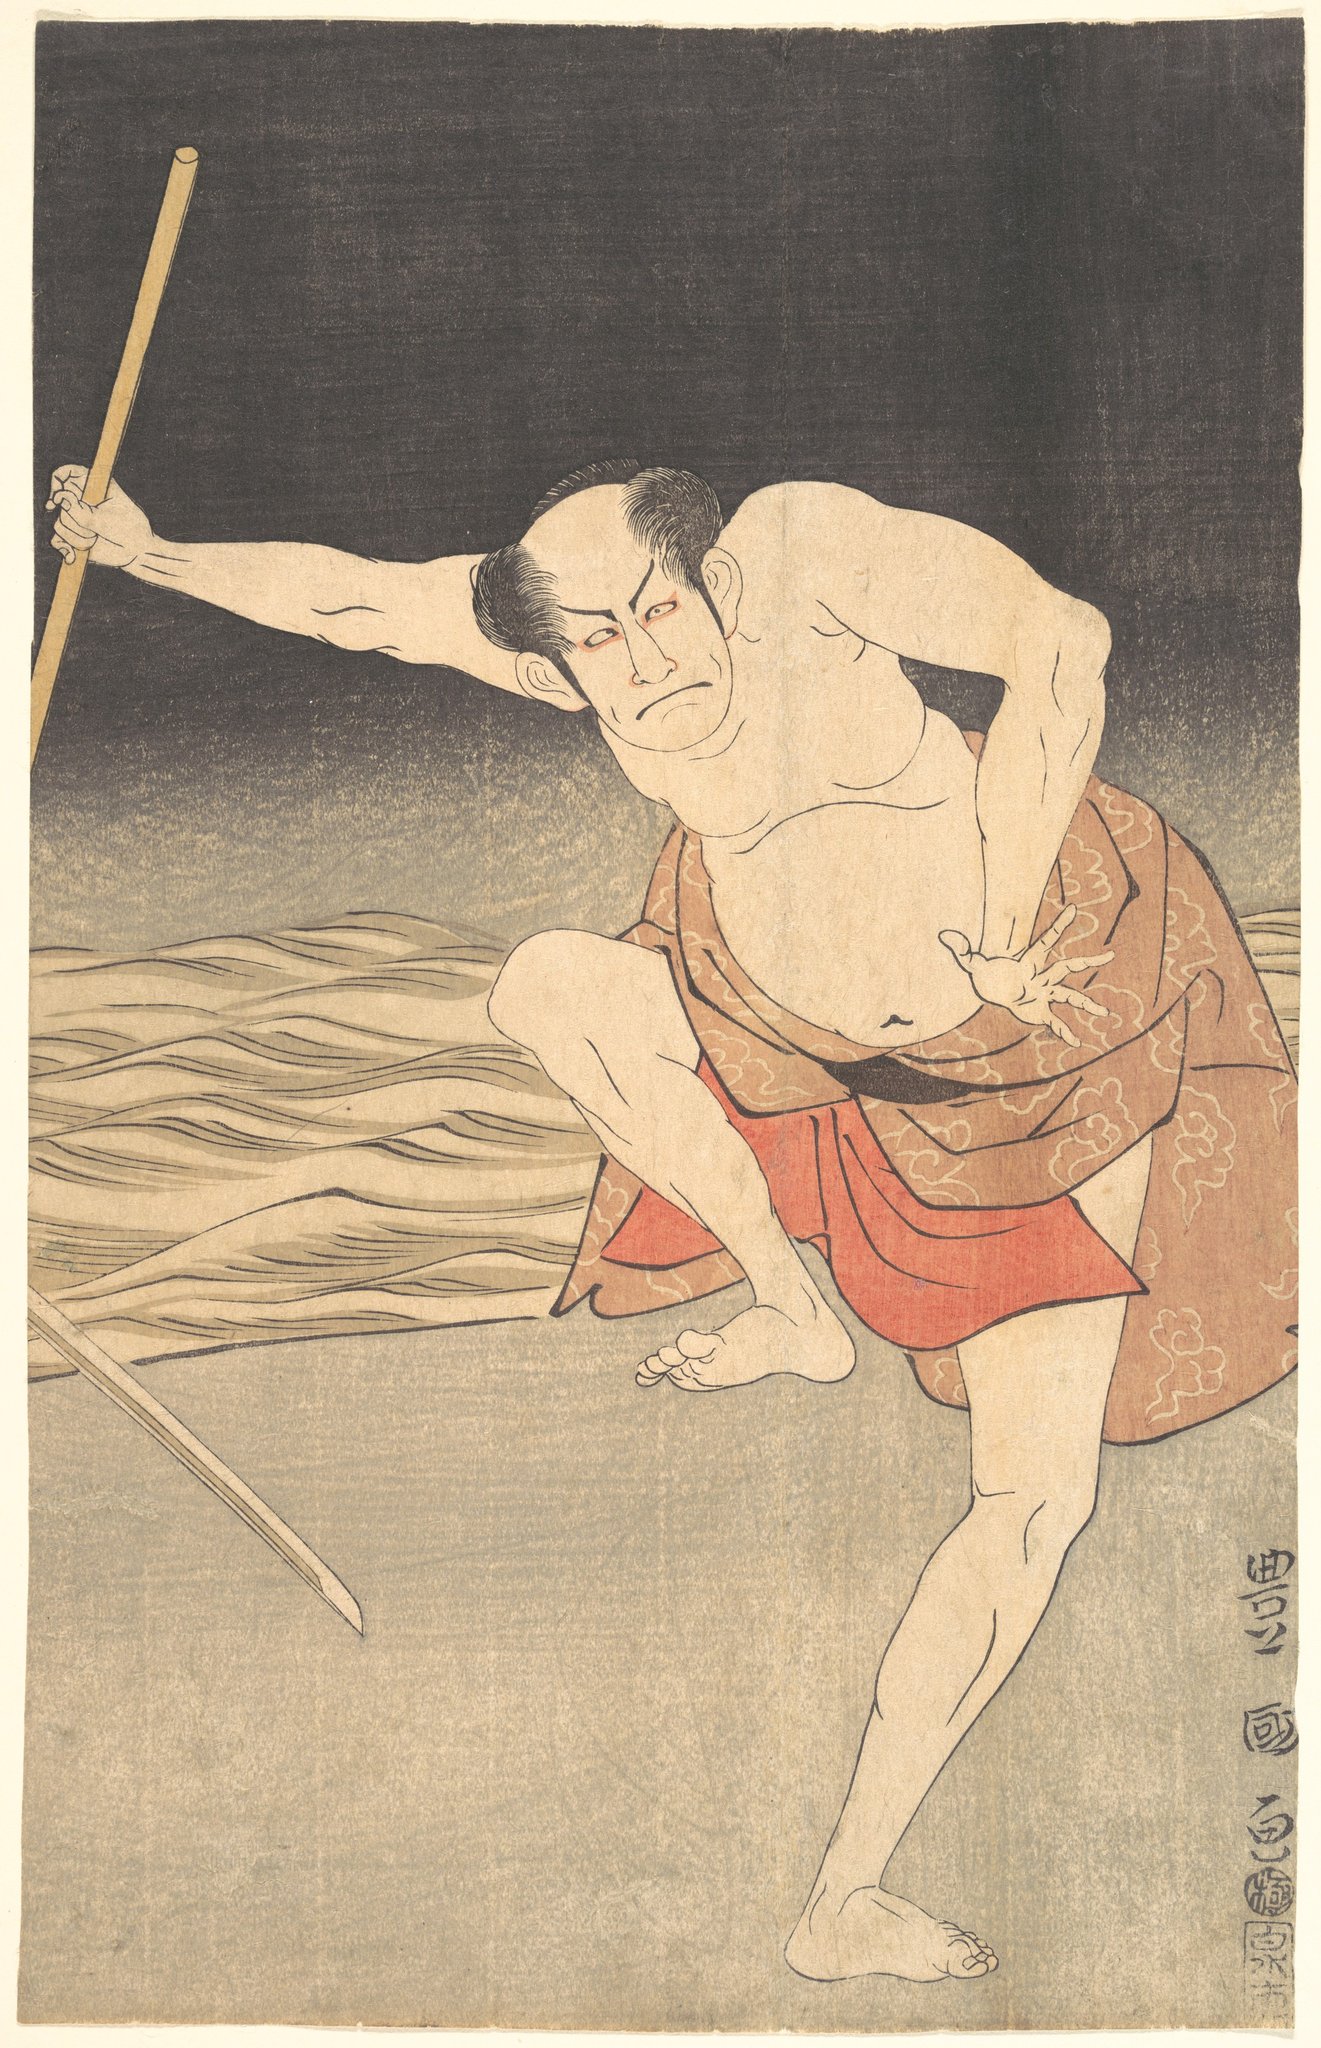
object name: print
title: An Actor Beside Water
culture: japanese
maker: utagawa toyokuni i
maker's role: artist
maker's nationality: japanese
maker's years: 1769-1825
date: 1615-1868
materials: ink, paper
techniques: woodblock print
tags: men,actors